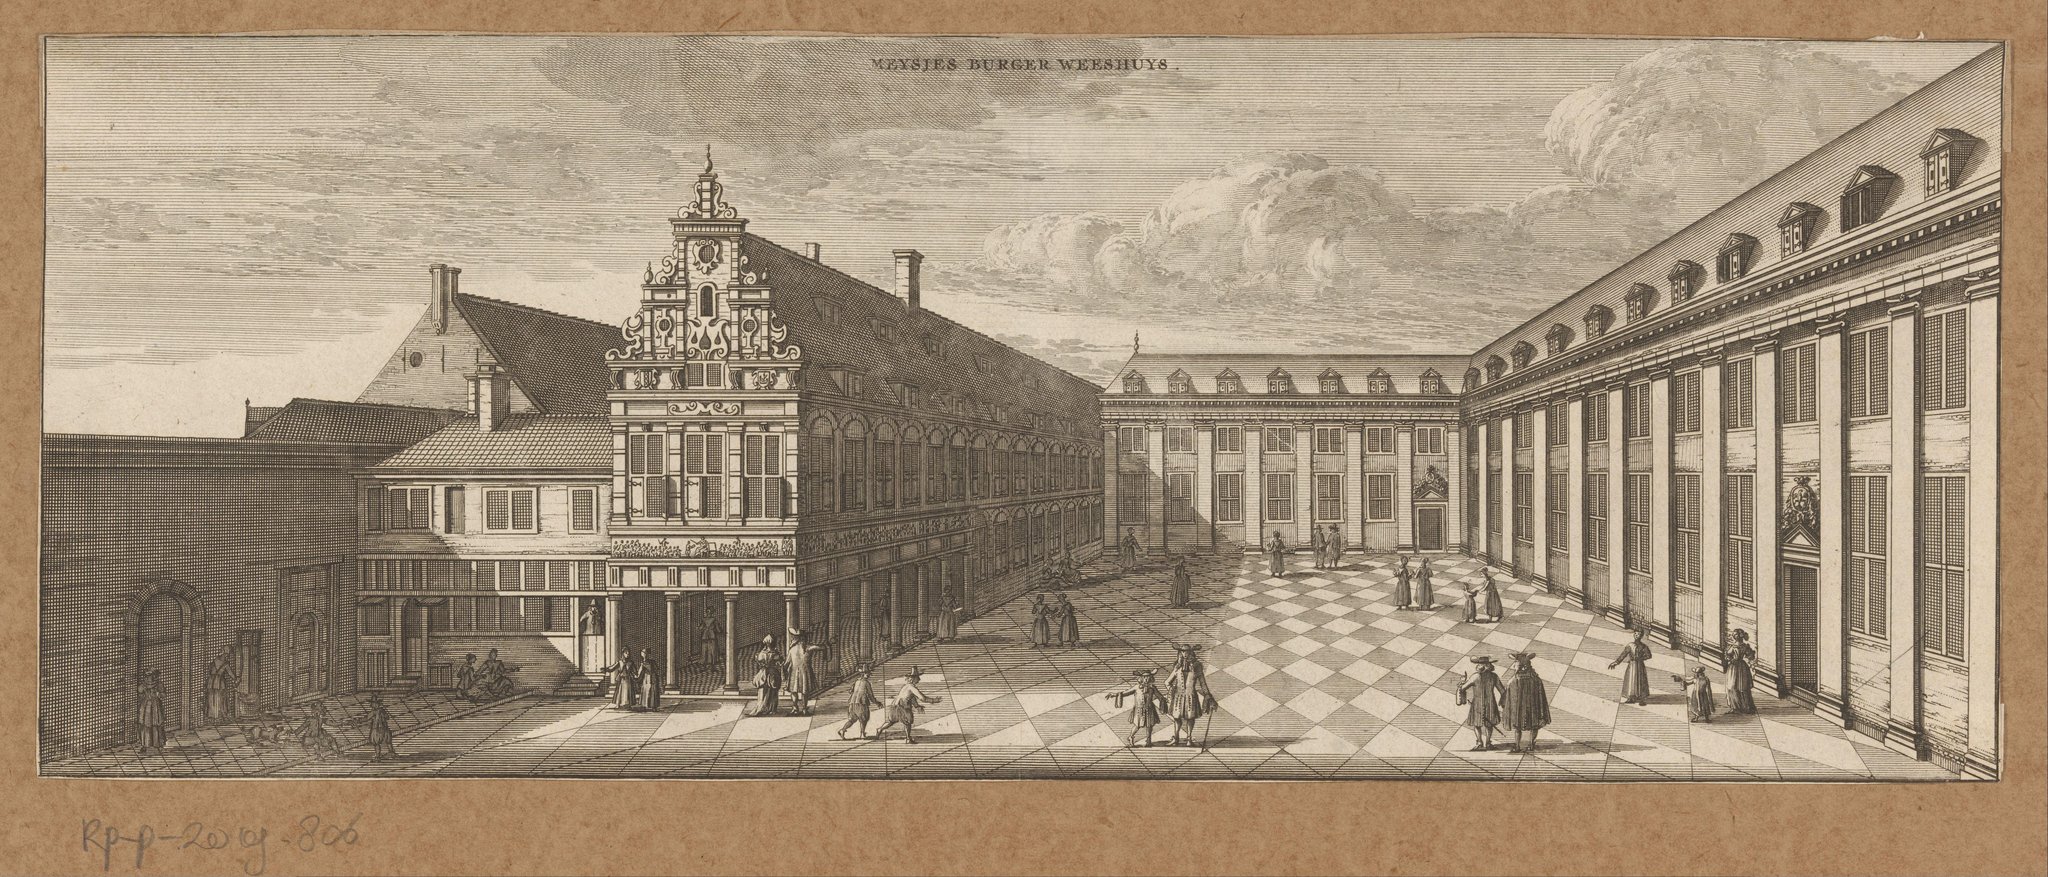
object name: print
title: Gezicht op het meisjeshuis van het Burgerweeshuis te Amsterdam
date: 1726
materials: paper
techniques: engraving, etching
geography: amsterdam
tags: public welfare, courtyard, orphanage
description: Prent uit: Commelin, Caspar. Beschryvinge van Amsterdam, zynde een naukeruige verhandelinge van desselfs eerste oorspronk uyt den Huyse (…). Amsterdam: Andries van Damme et al., 1726, tussen p. 560 en 561. Eerdere staat komt voor in publicaties uit 1693 en 1694.